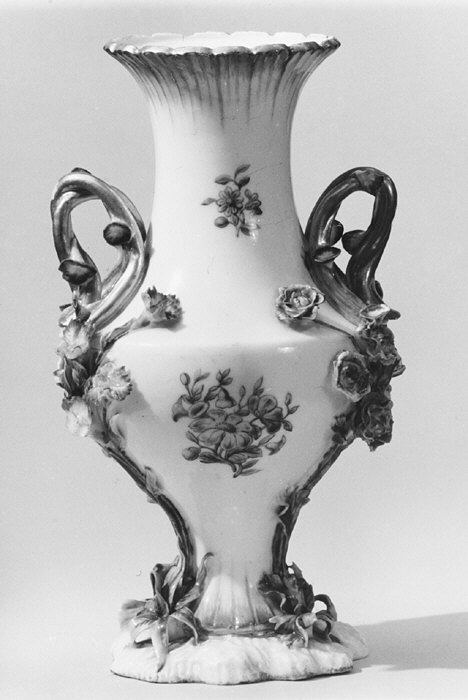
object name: vase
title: Vase (vase Duplessis) (one of a group of three)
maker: vincennes manufactory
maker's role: manufactory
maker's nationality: french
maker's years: 1740-1756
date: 1752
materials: soft paste porcelain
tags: flowers